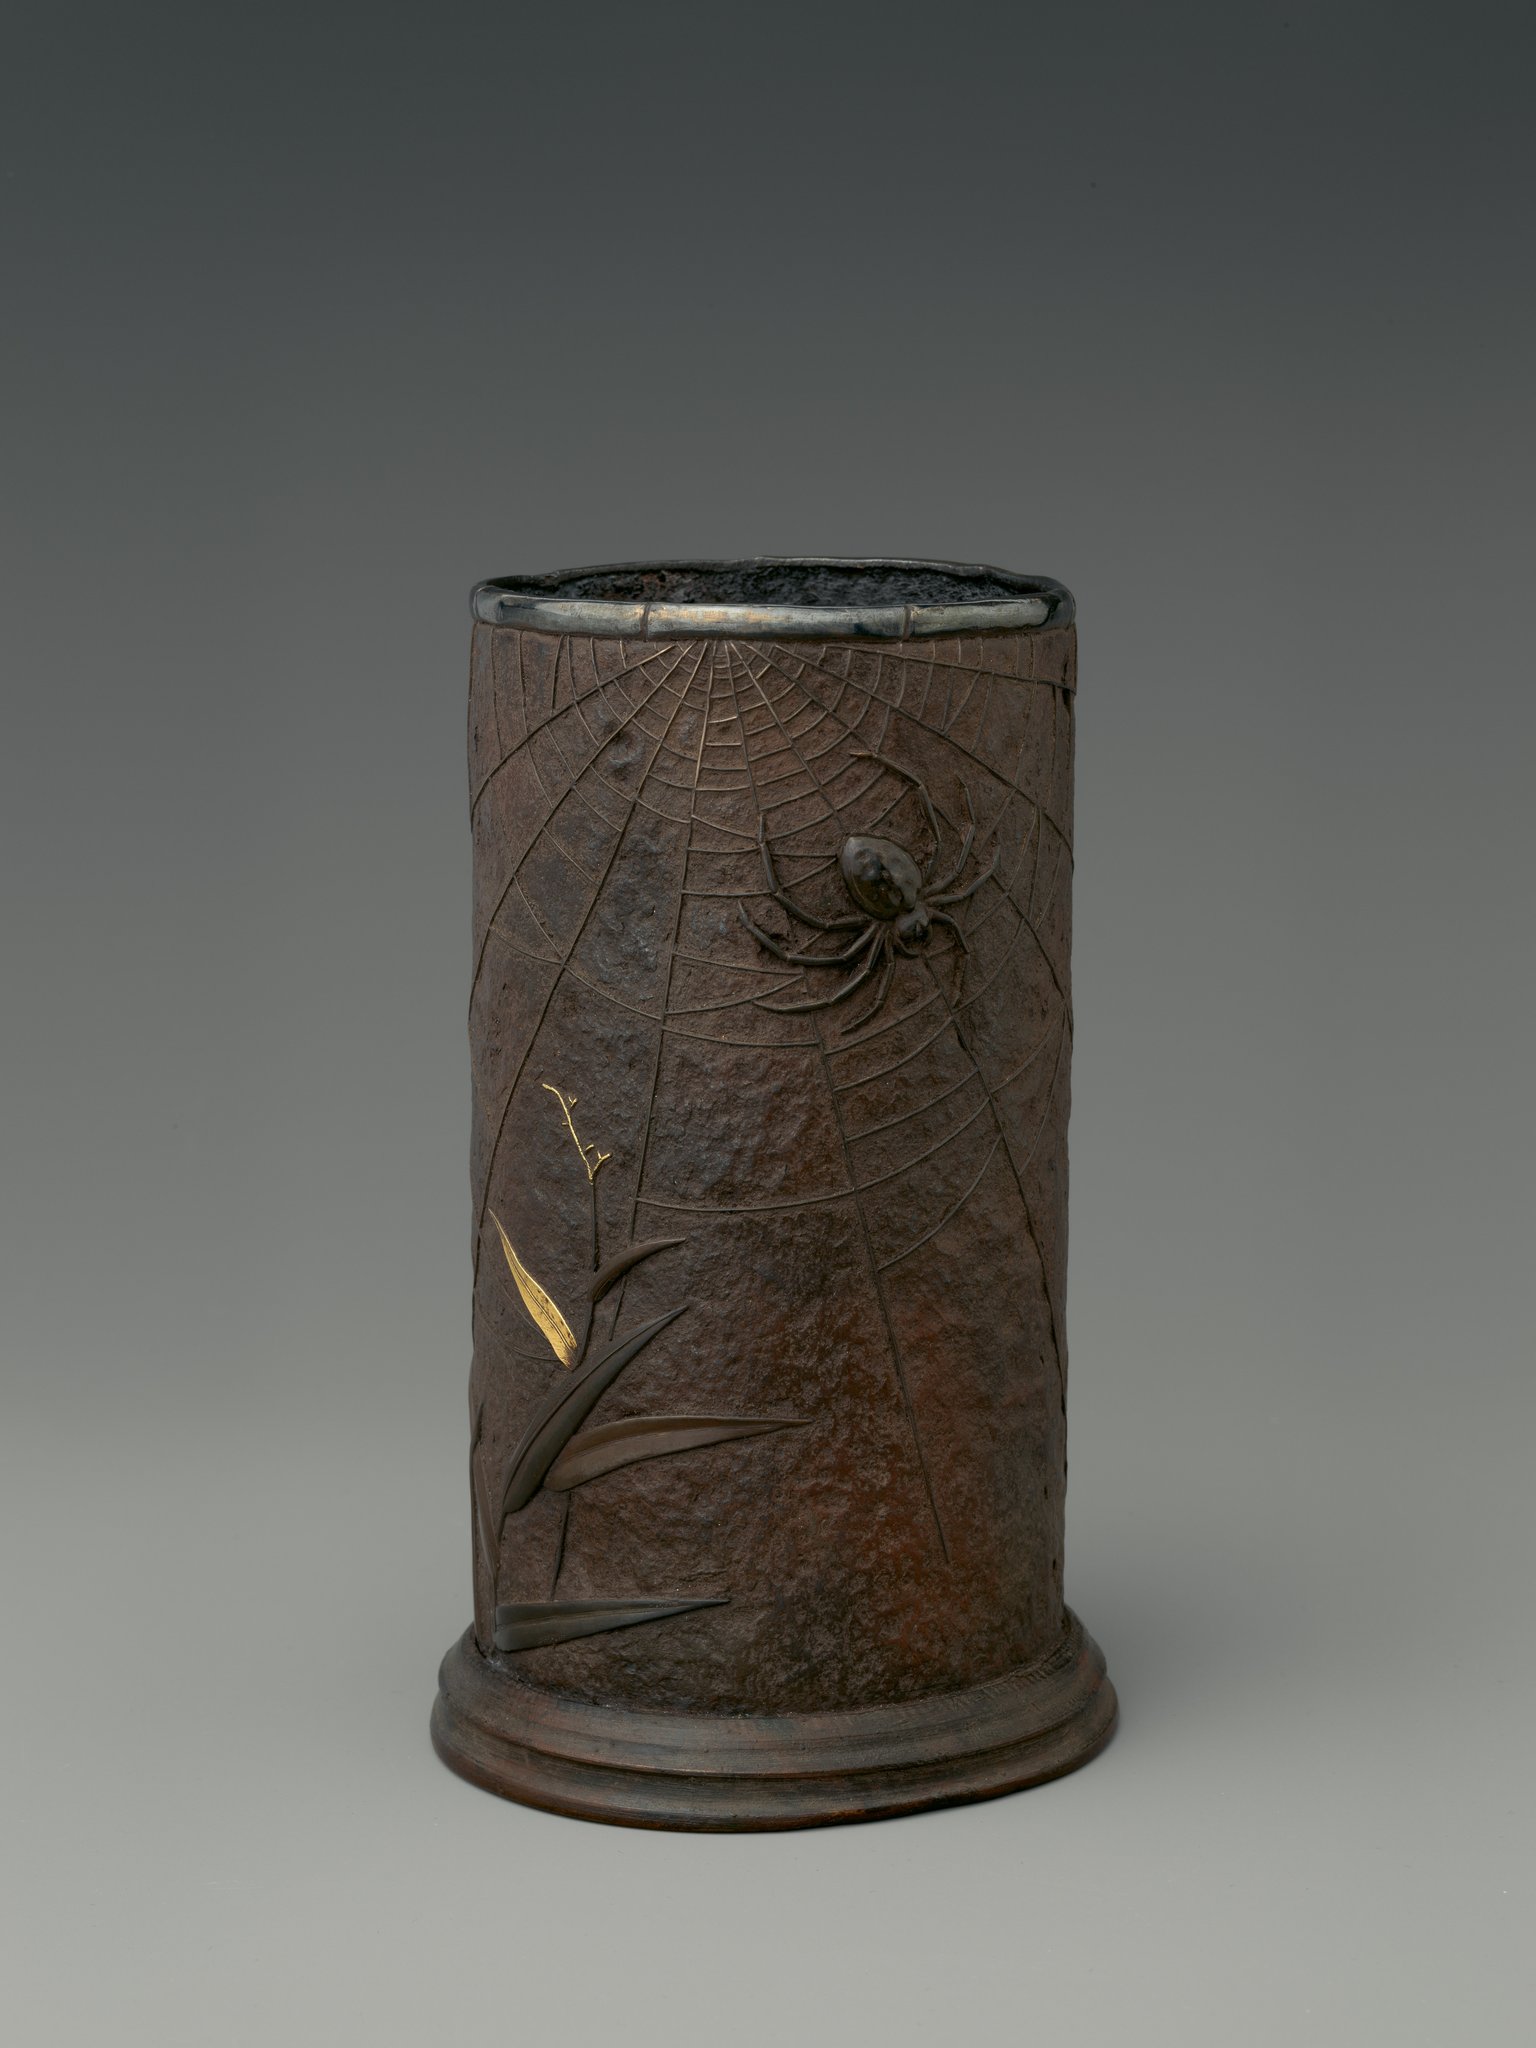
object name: brush holder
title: Brush Holder (Fude-zutsu)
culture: japanese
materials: iron, gold, metal alloy, silver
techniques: inlay, relief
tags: spiders